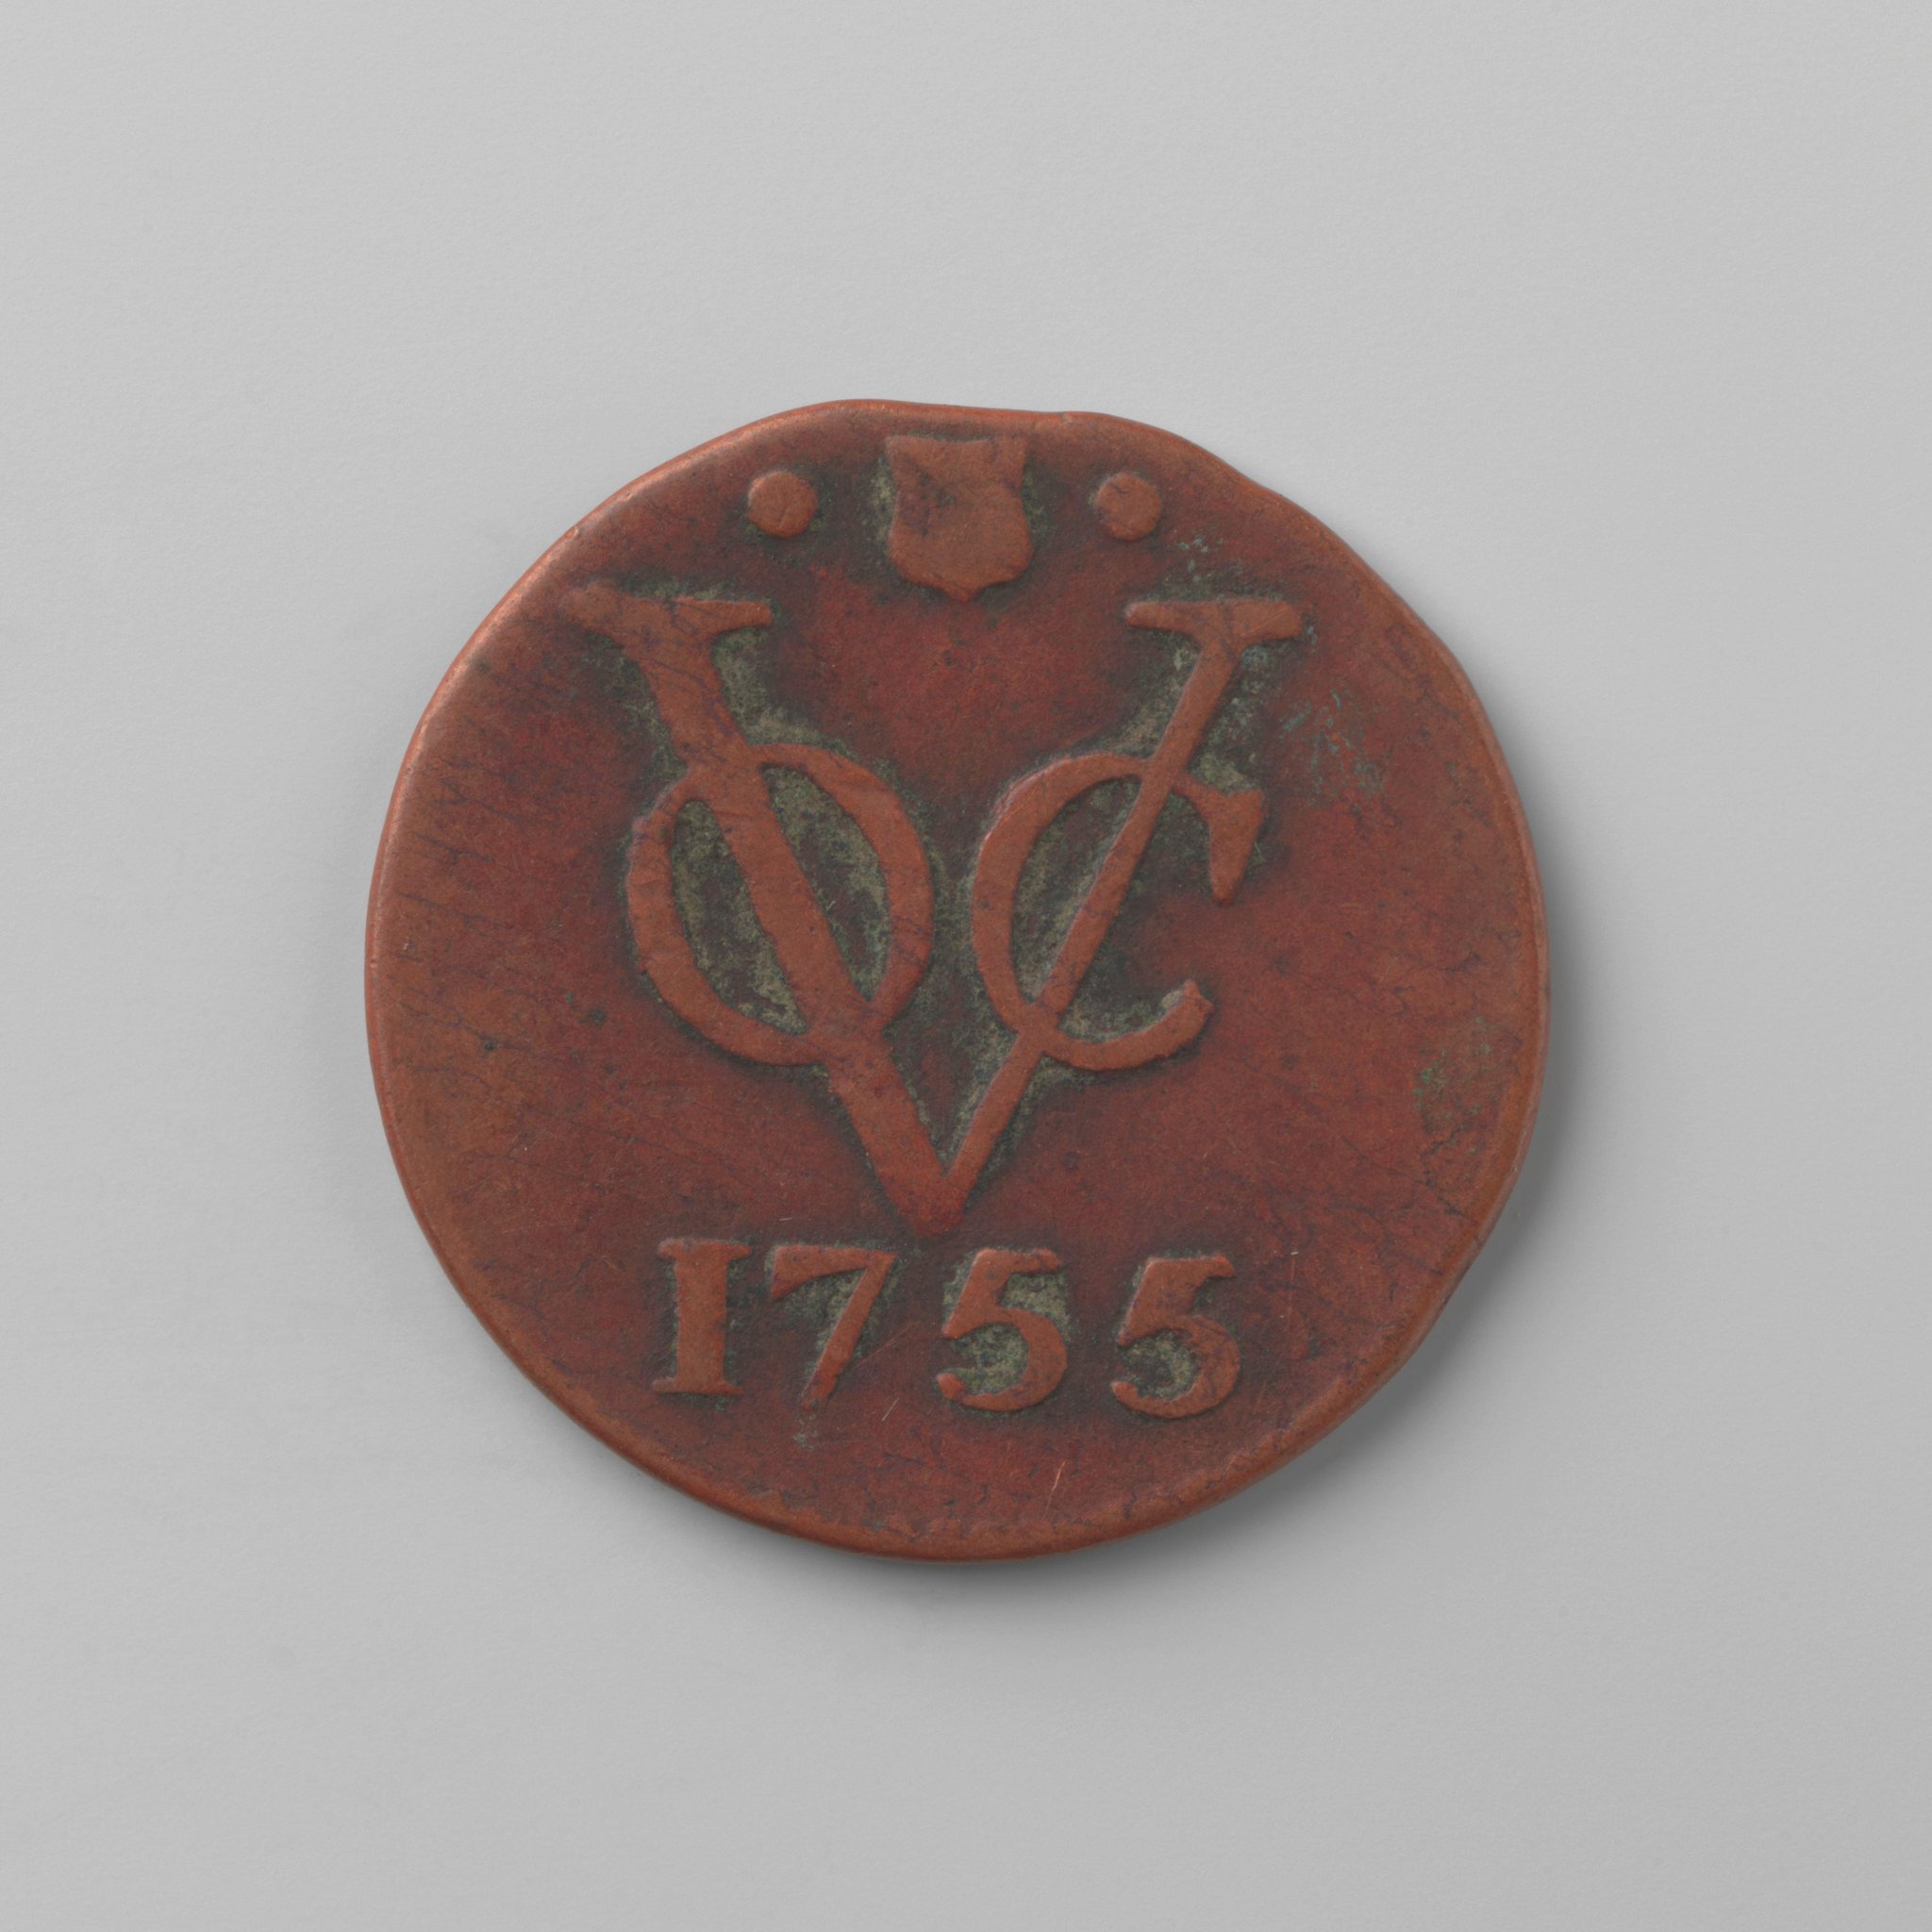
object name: coin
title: Duit van de VOC uit de stad Utrecht,1755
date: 1755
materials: copper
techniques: striking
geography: utrecht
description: Koperen munt. Voorzijde: op balk, waaronder guirlande, geplaatst, door twee leeuwen gehouden gekroond wapenschild van de stad Utrecht. Keerzijde: monogram van de VOC, waarboven muntteken en waaronder jaartal. Gladde rand.